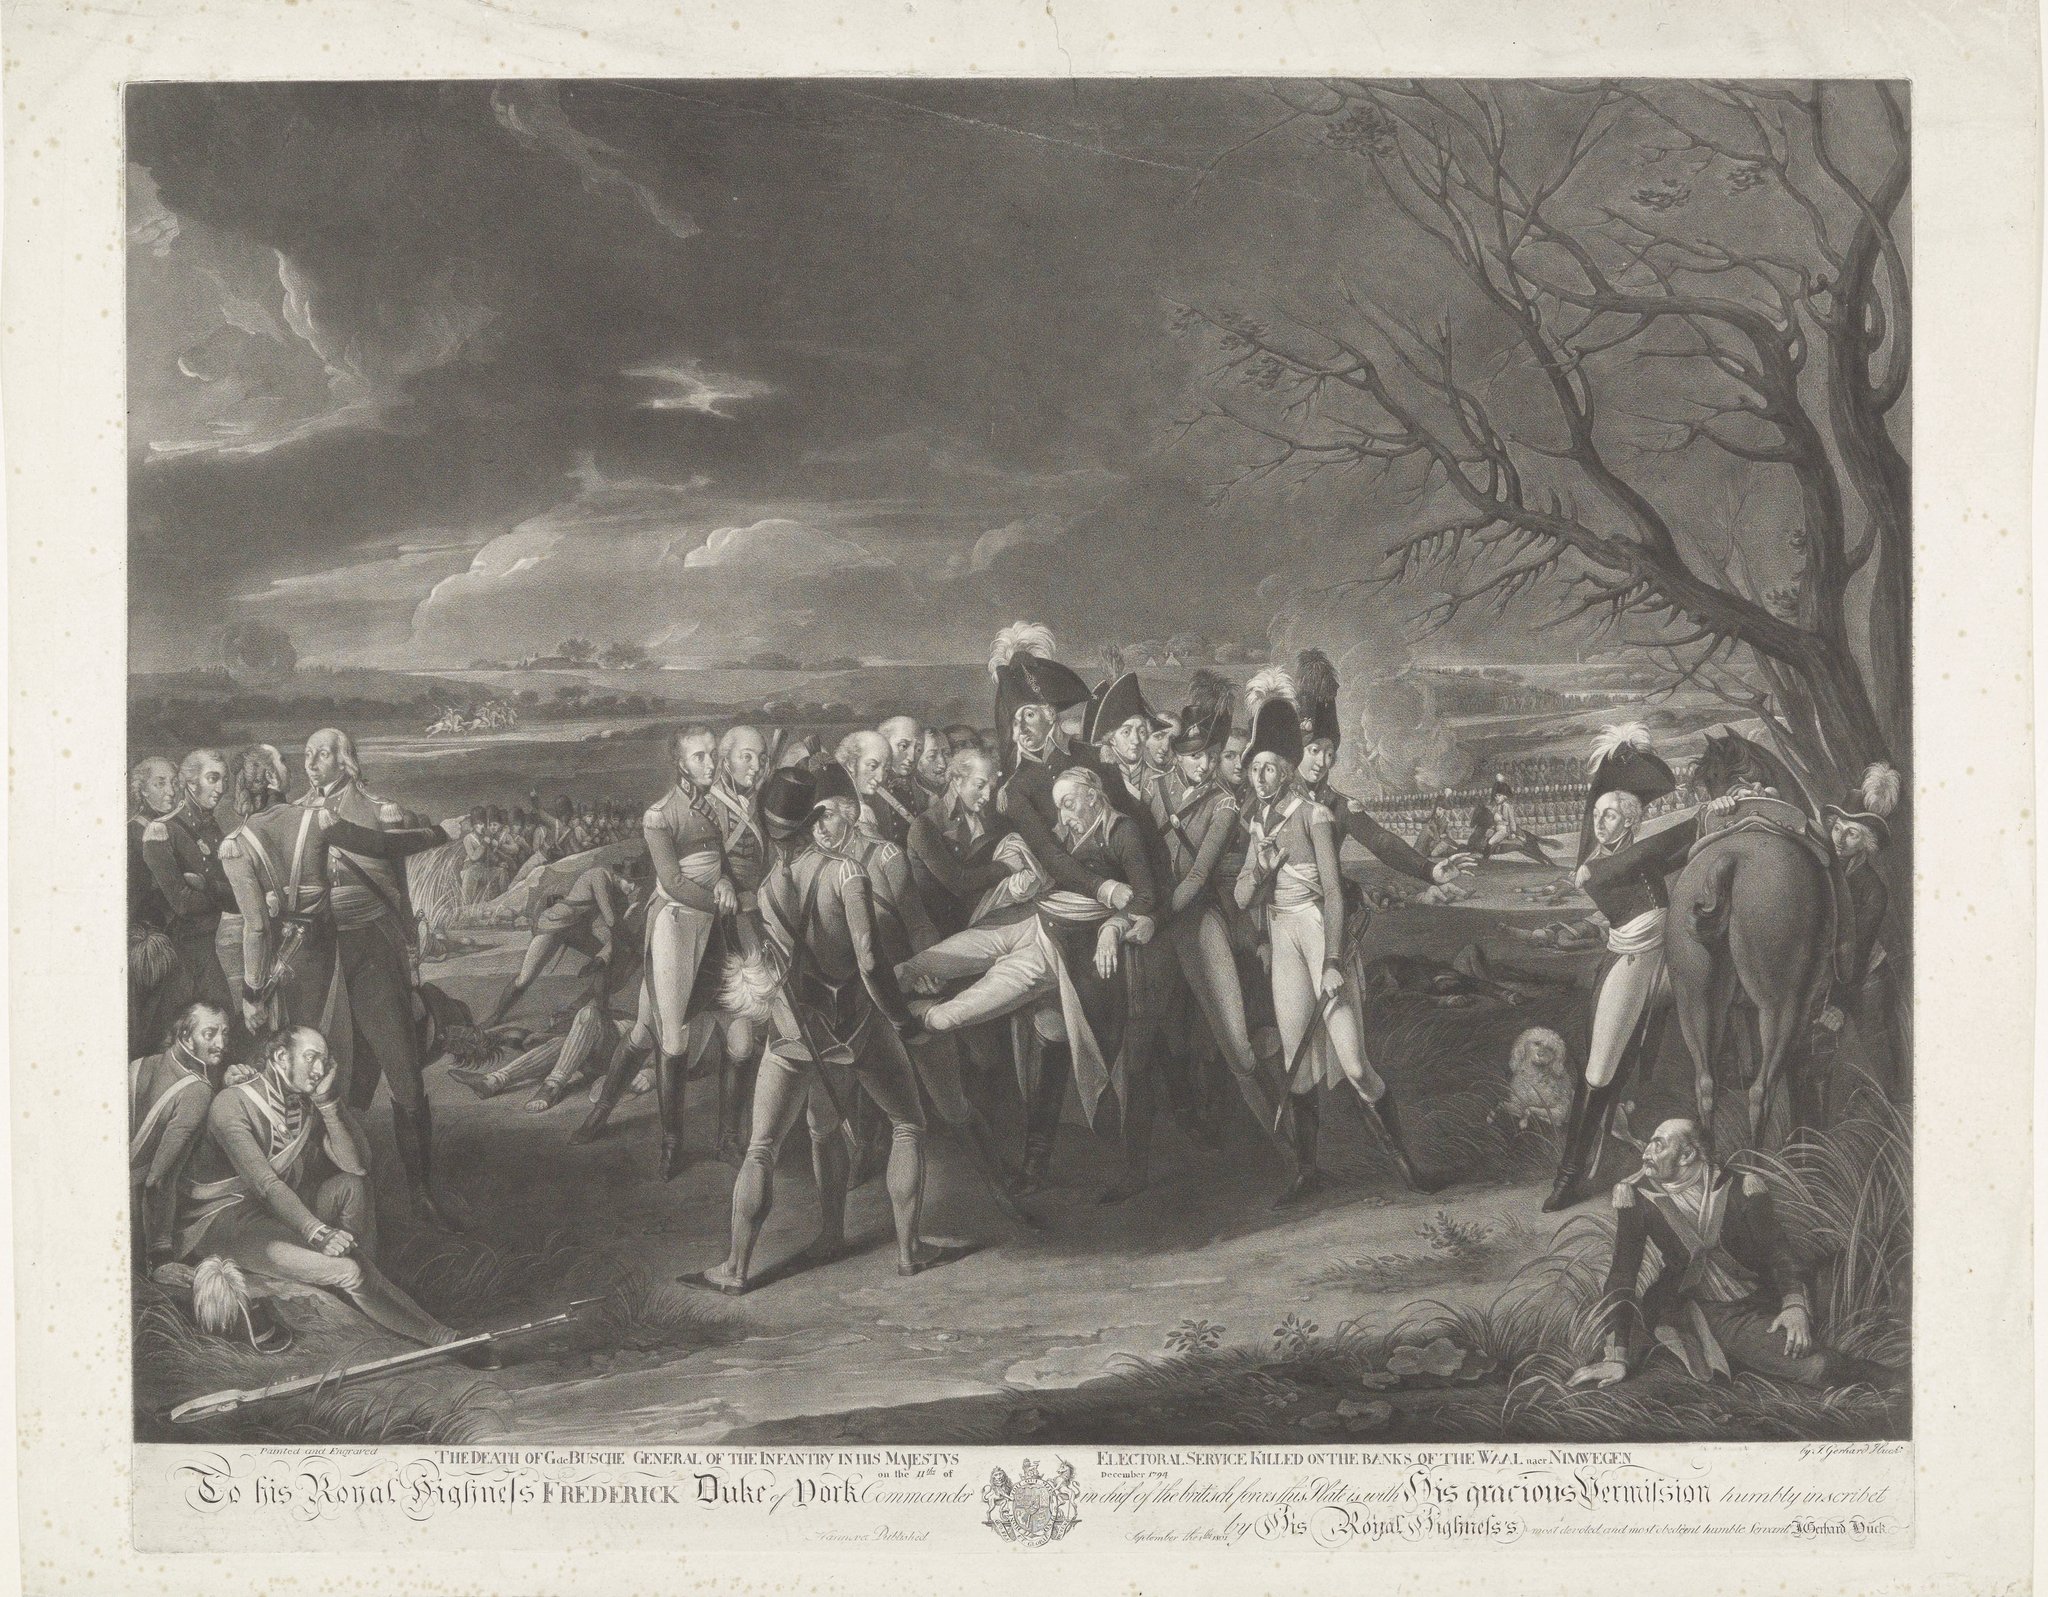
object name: history print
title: Dood van generaal Bussche, 1794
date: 1801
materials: paper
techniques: etching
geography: hannover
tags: violent death, being killed; being mishandled and maltreated; seeking death, battle (+ land forces), nijmegen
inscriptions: collector's mark: Lugt 2228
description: Dood van generaal Georg Wilhelm Bussche, 11 december 1794 (moet zijn 7 november). De Duitse generaal in dienst van de Britse troepen in slag met de Franse troepen aan de oever van de Waal bij de inname van Nijmegen. De rechterhand van de generaal is door een Franse kanonskogel afgeschoten, hieraan bezwijkt hij. Het lichaam van de generaal wordt door zijn zoons en anderen weggedragen. Bij de prent behoort een aparte sleutel tot de voorstelling.